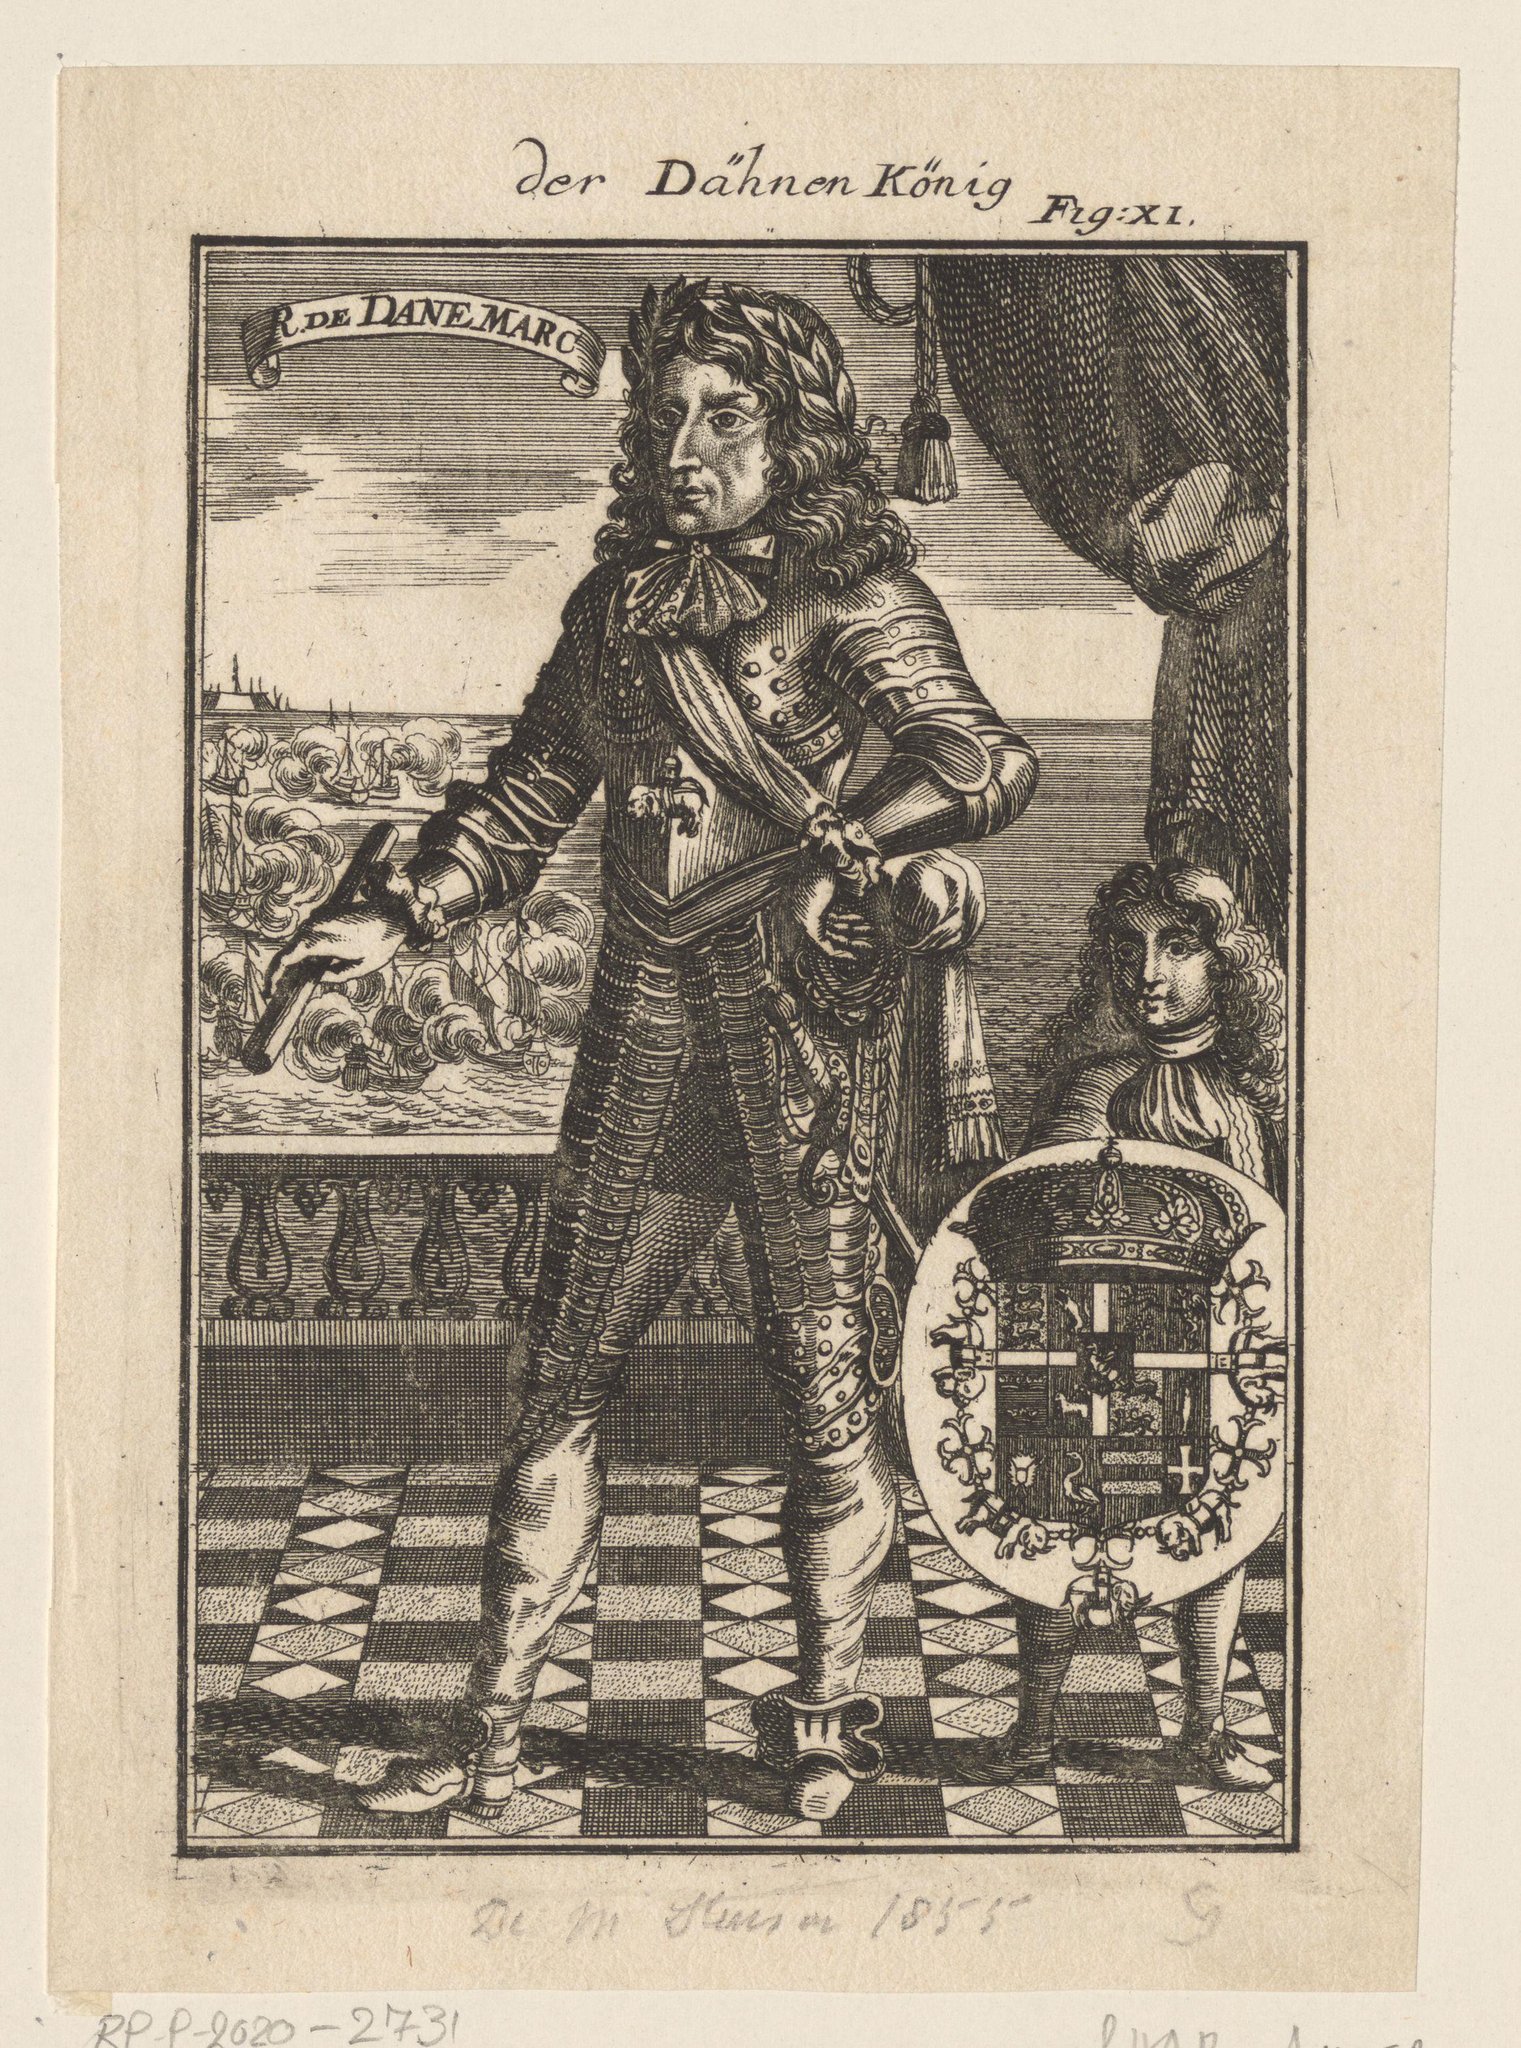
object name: print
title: Portret van Christiaan V, koning van Denemarken en Noorwegen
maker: Anonymous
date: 1680-1749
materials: paper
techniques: engraving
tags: copenhagen (city), historical persons, ships (in general), war, king, armorial bearing, heraldry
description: Rechtsboven genummerd: Fig: XI. Rechts van de geportretteerde zijn wapenschild.